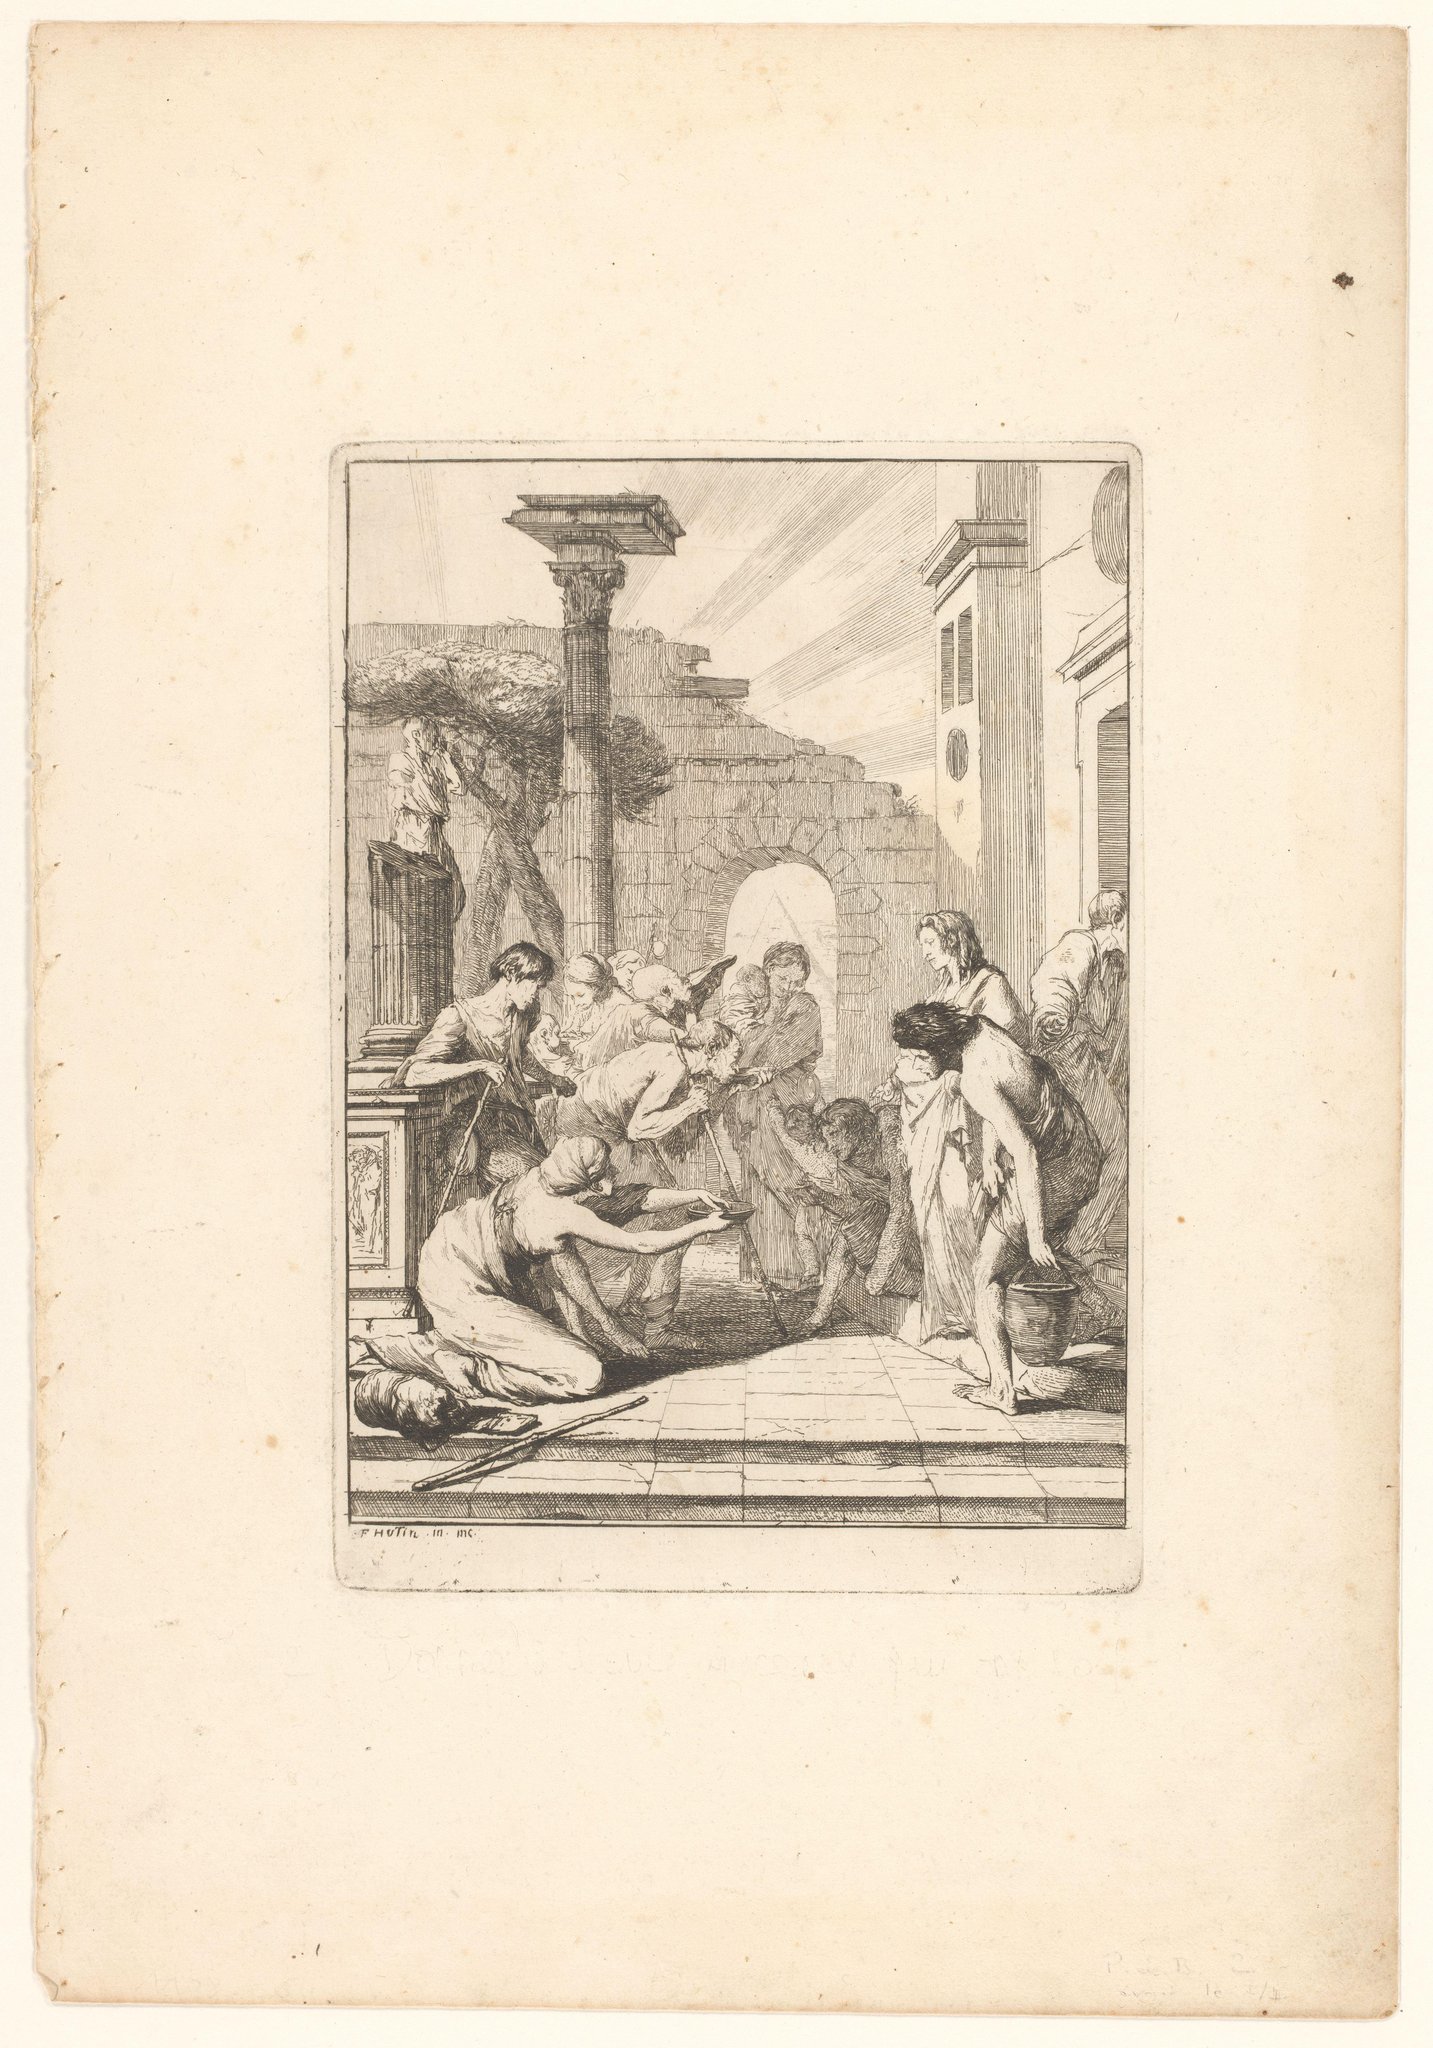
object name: print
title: Het laven van dorstigen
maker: françois hutin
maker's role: painter, print maker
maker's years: 1685-1758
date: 1730-1750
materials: paper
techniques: etching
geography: dresden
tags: giving the thirsty to drink, 'sitiens potatur' ~ one of the (seven) acts of mercy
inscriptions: collector's mark: Lugt 2760, collector's mark: Lugt 2228, collector's mark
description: Onderdeel van een serie van zeven werken van barmhartigheid met voorstellingen in antieke setting.